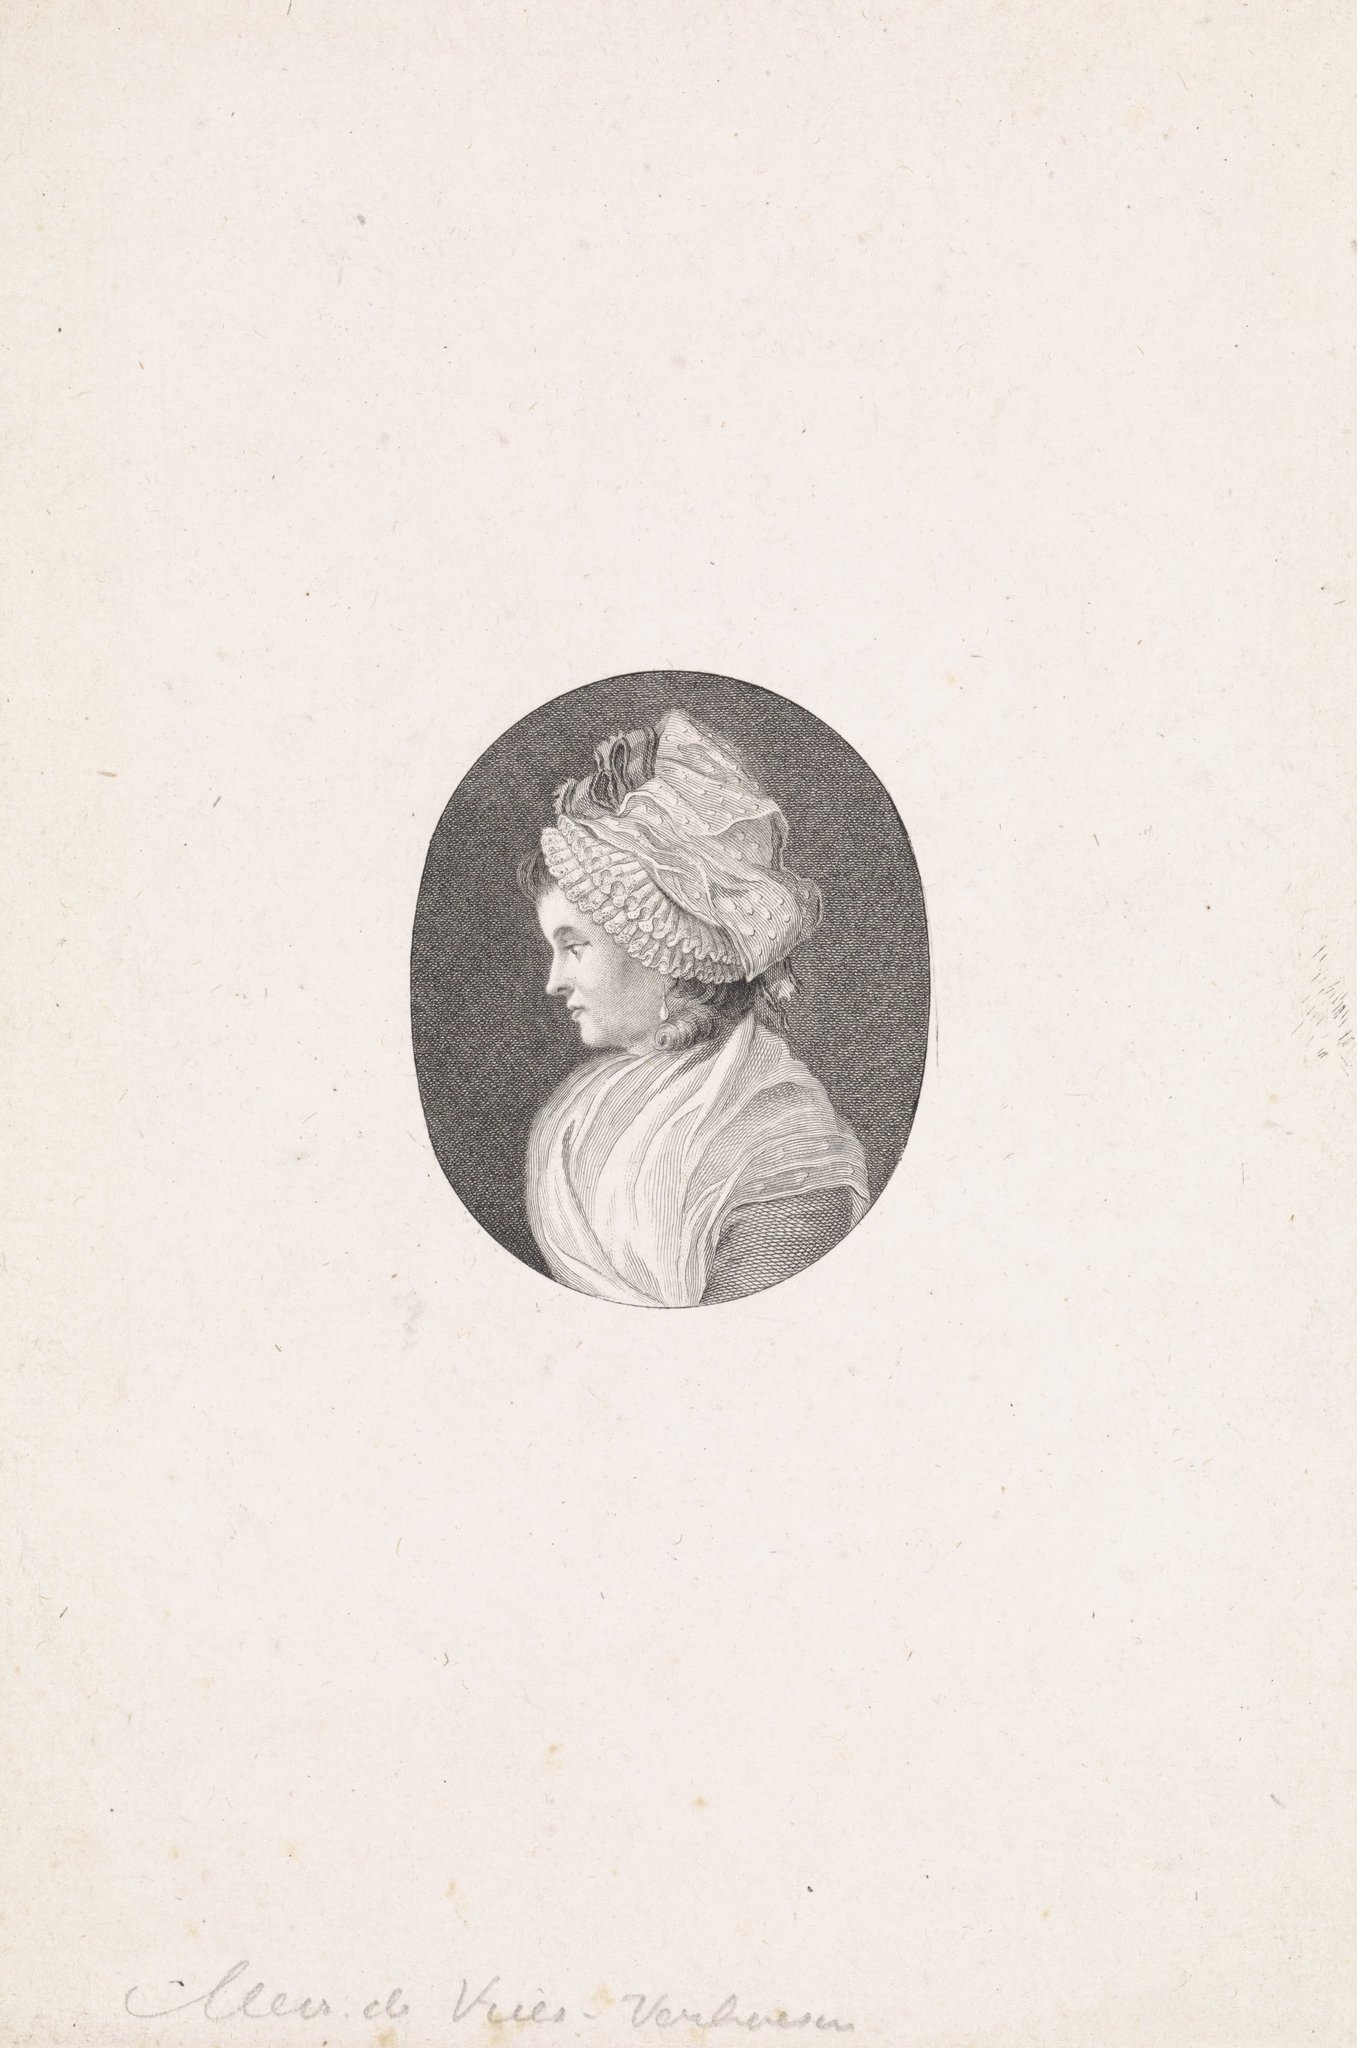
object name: print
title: Portret van Maria Gysberta Verhoesen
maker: reinier vinkeles (i)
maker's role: draughtsman, print maker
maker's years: 1741-1816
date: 1800-1802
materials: paper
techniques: engraving, etching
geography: amsterdam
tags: maria gysberta verhoesen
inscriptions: collector's mark: Lugt 2228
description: Portret van Maria Gysberta Verhoesen, echtgenote van Jeronimo de Vries.